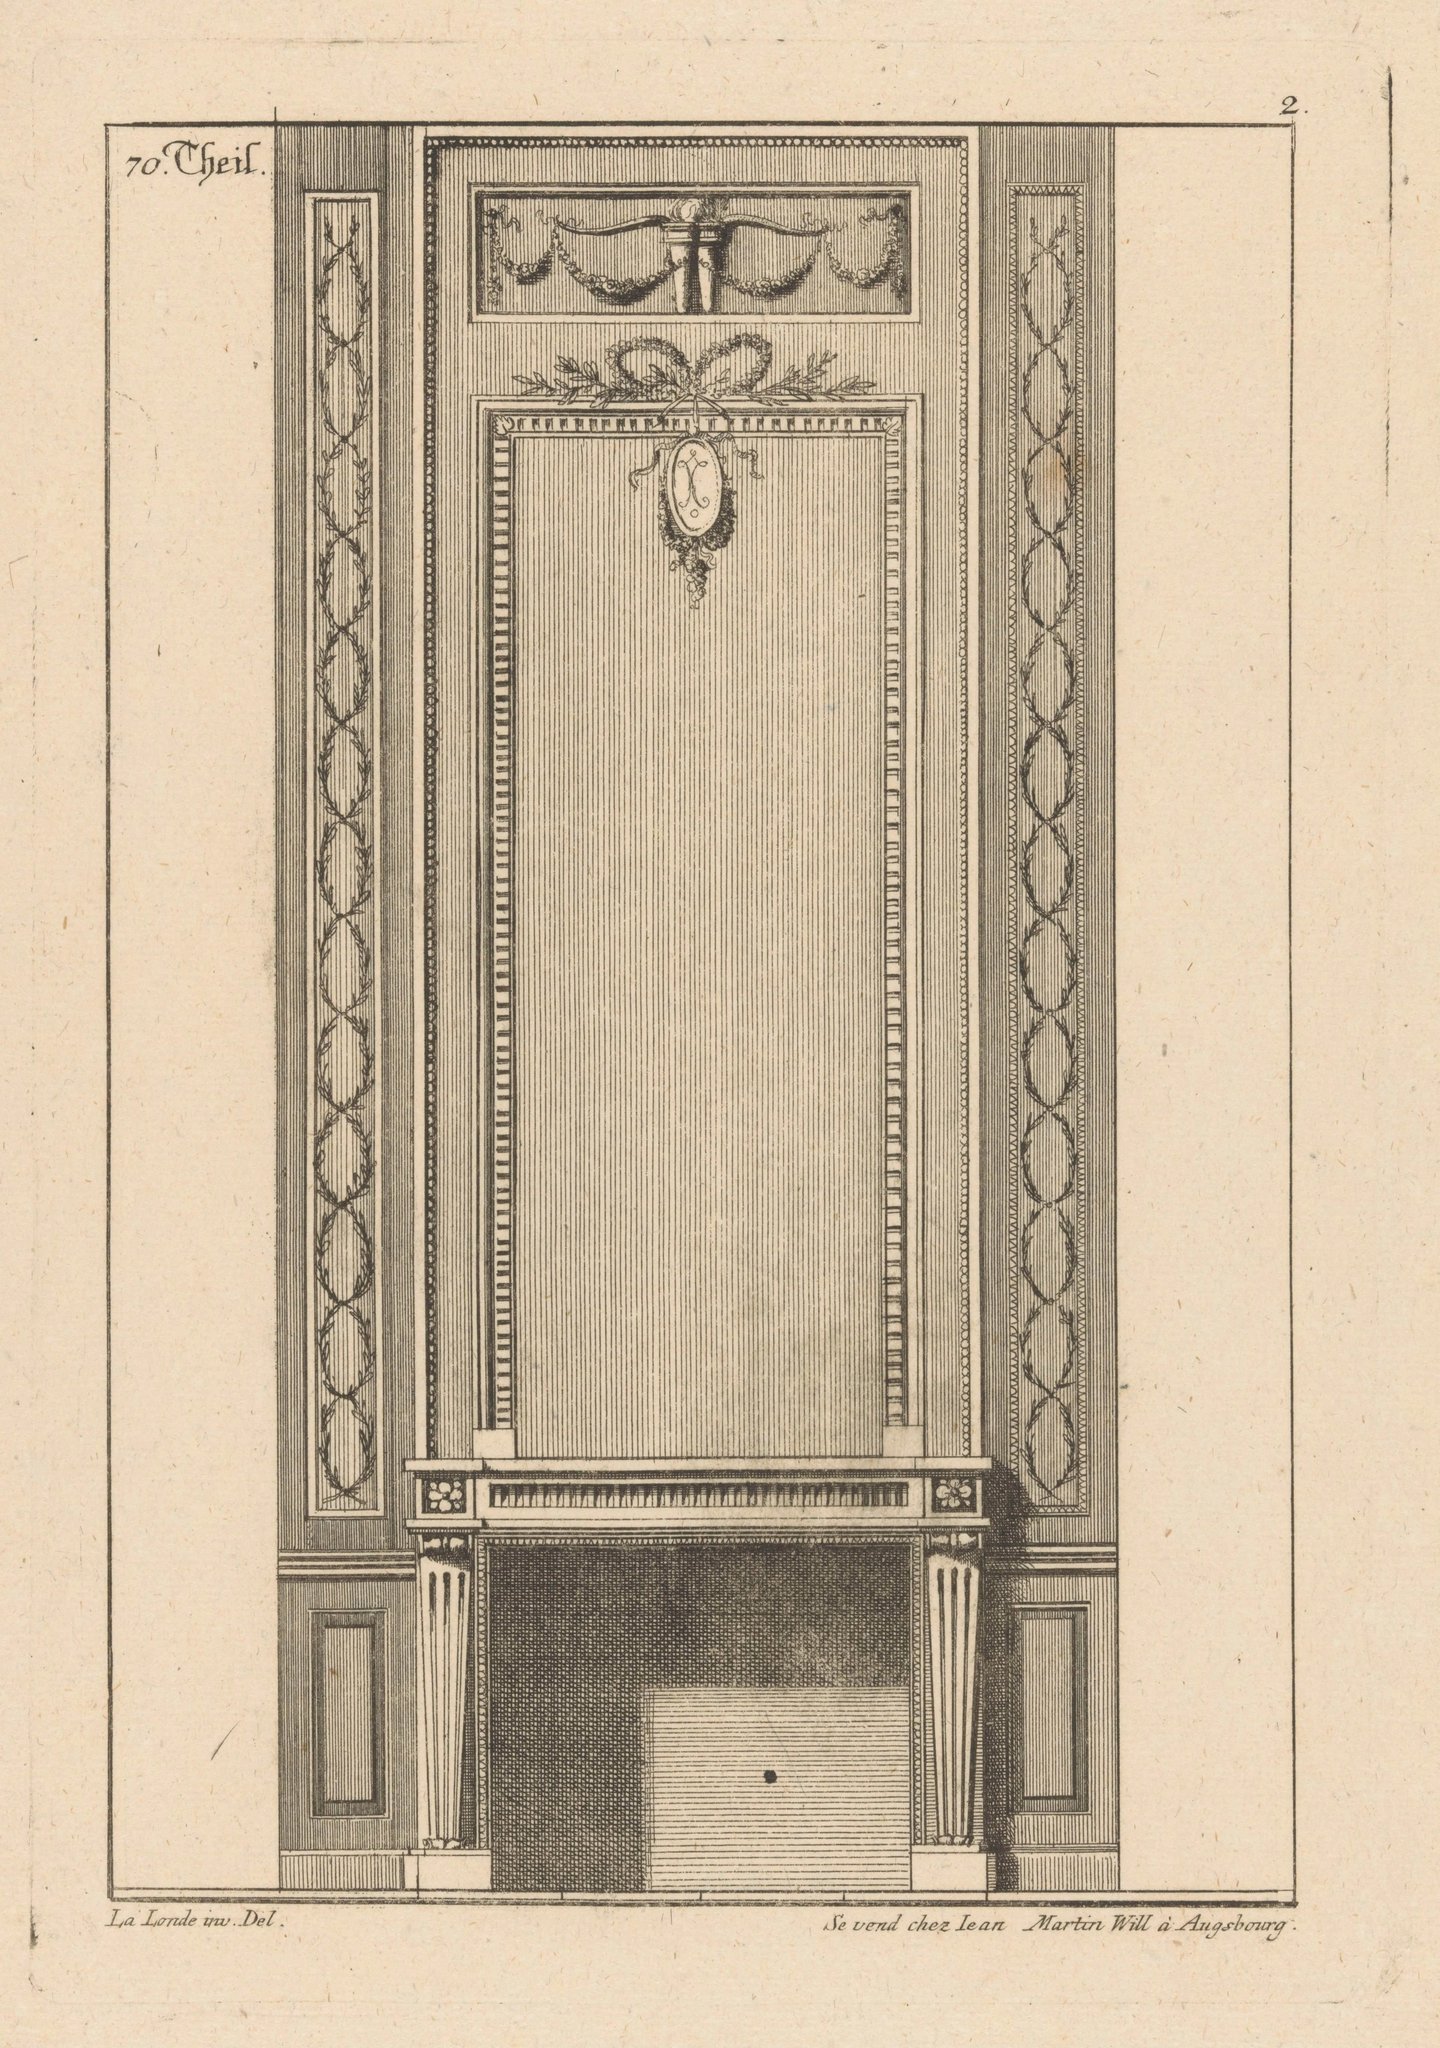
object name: ornament print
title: Schouw met medaillon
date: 1784-1806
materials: paper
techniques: engraving, etching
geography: augsburg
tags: ornament ~ medallion, open hearth, fire-place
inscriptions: collector's mark: Lugt 2228, collector's mark: Lugt 2760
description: Een geornamenteerde schouw met een ovaal medaillon. Aan de bovenzijde aan paneel met guirlandes, een pijlenkoker, een fakkel en een boog. Aan weerszijden van de schouw panelen met ranken.